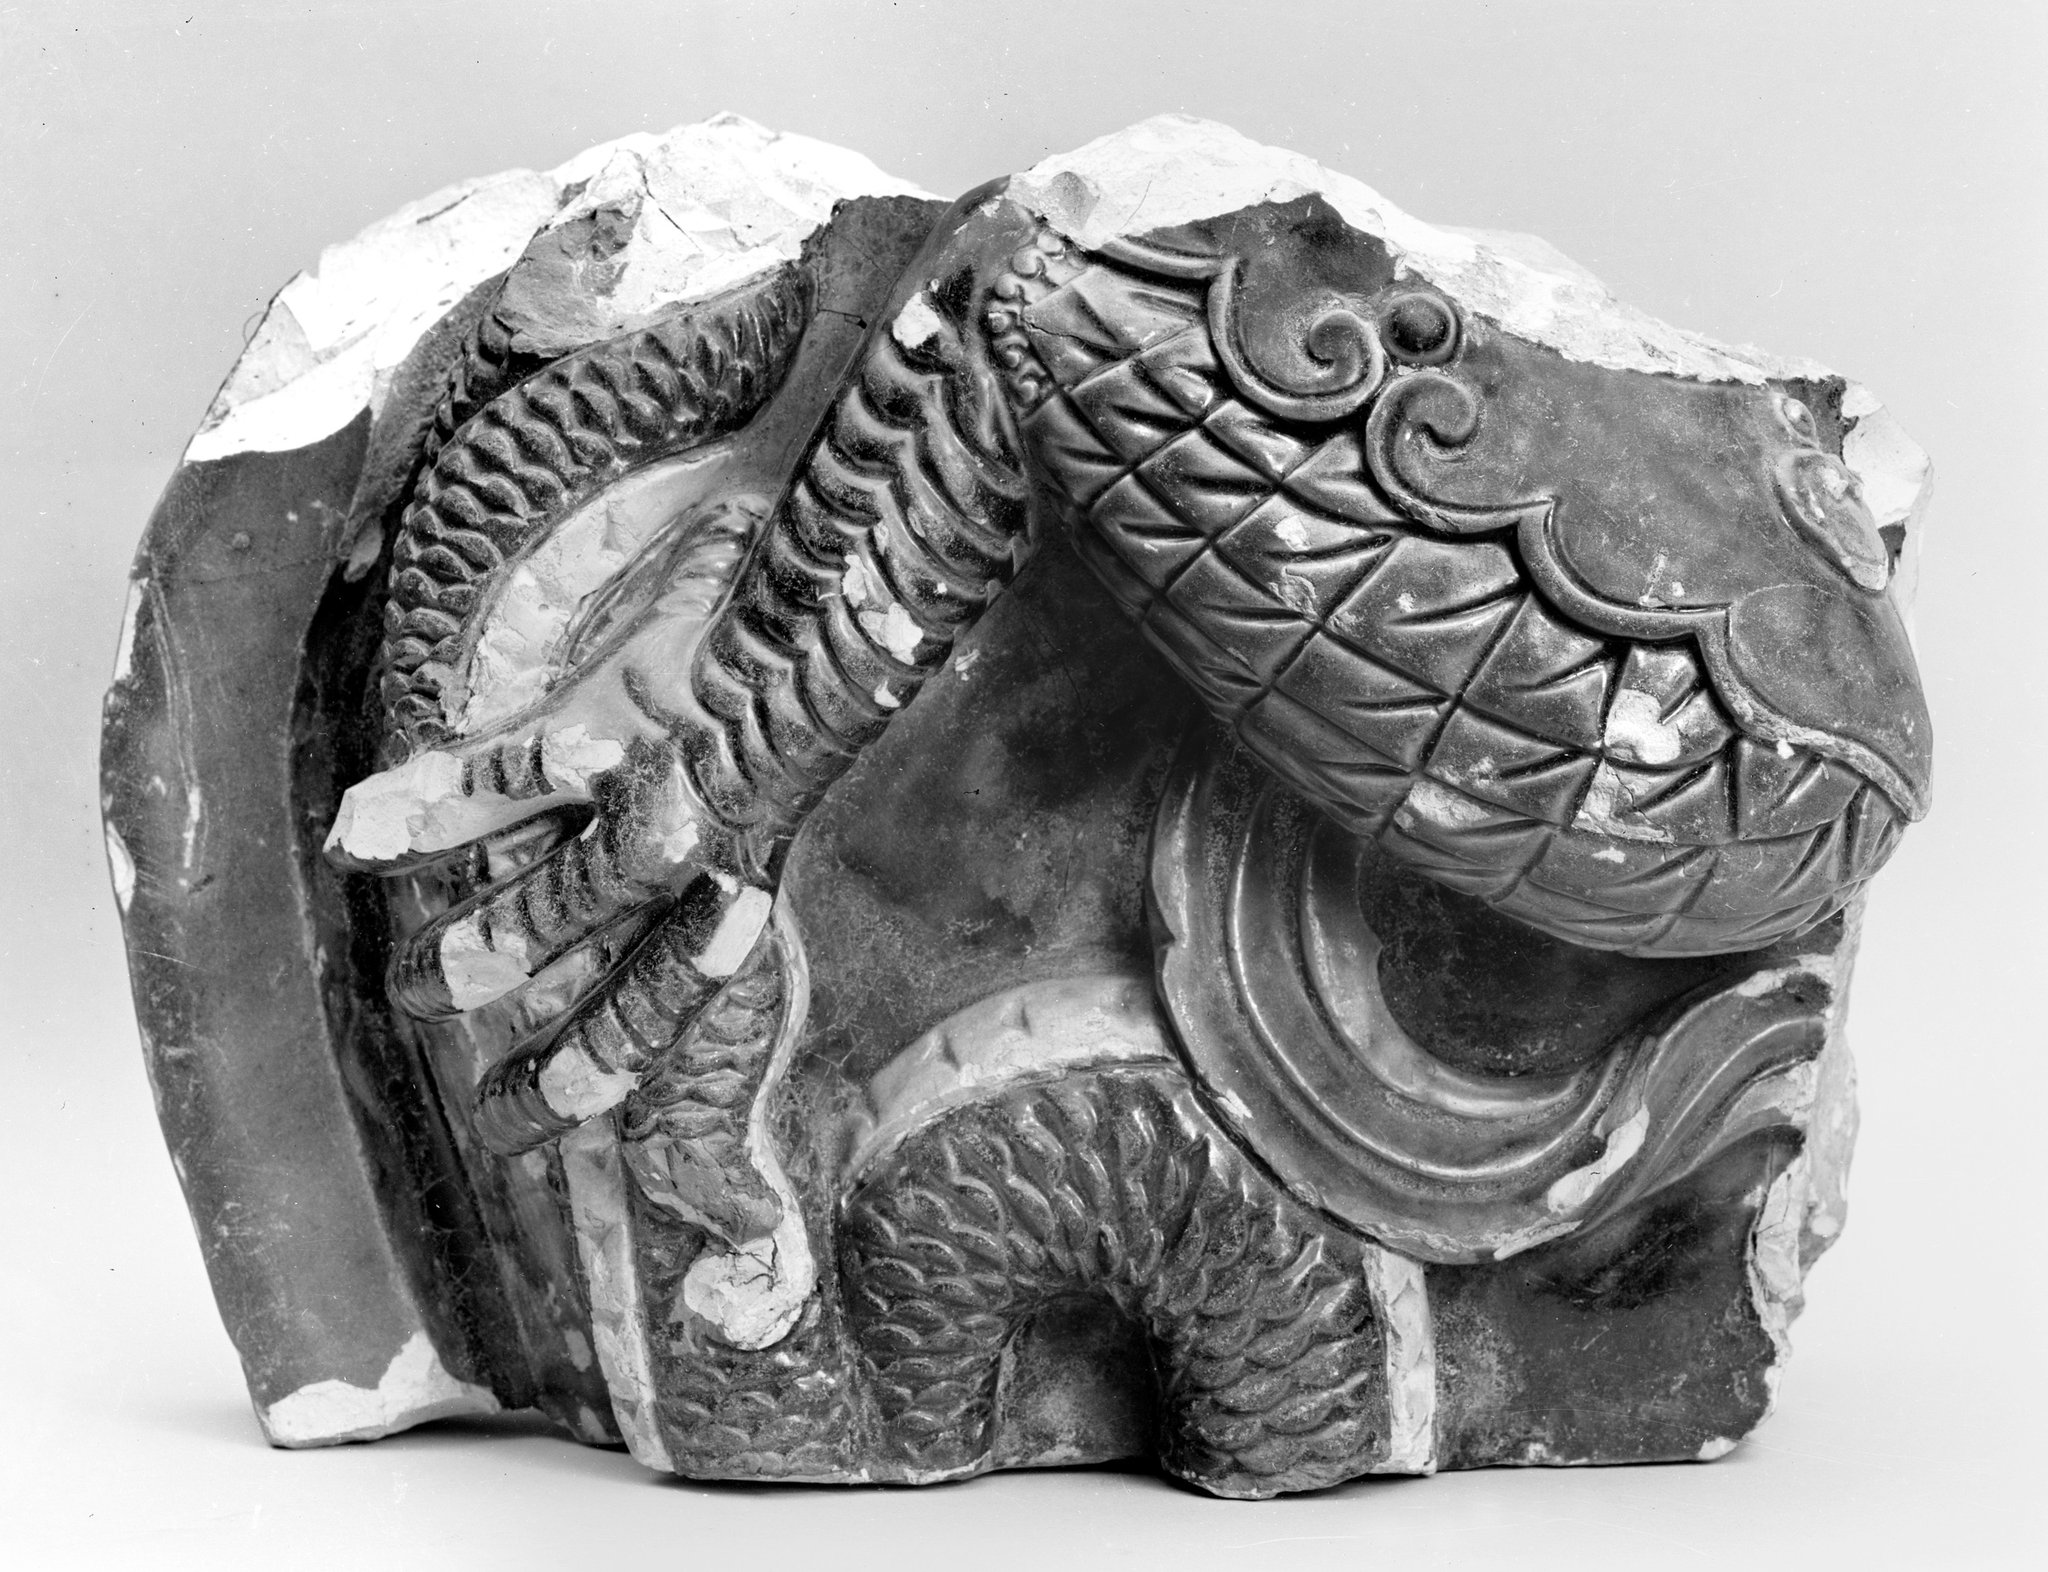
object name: tile fragment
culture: chinese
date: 1401-1433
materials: enamel, pottery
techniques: polychrome